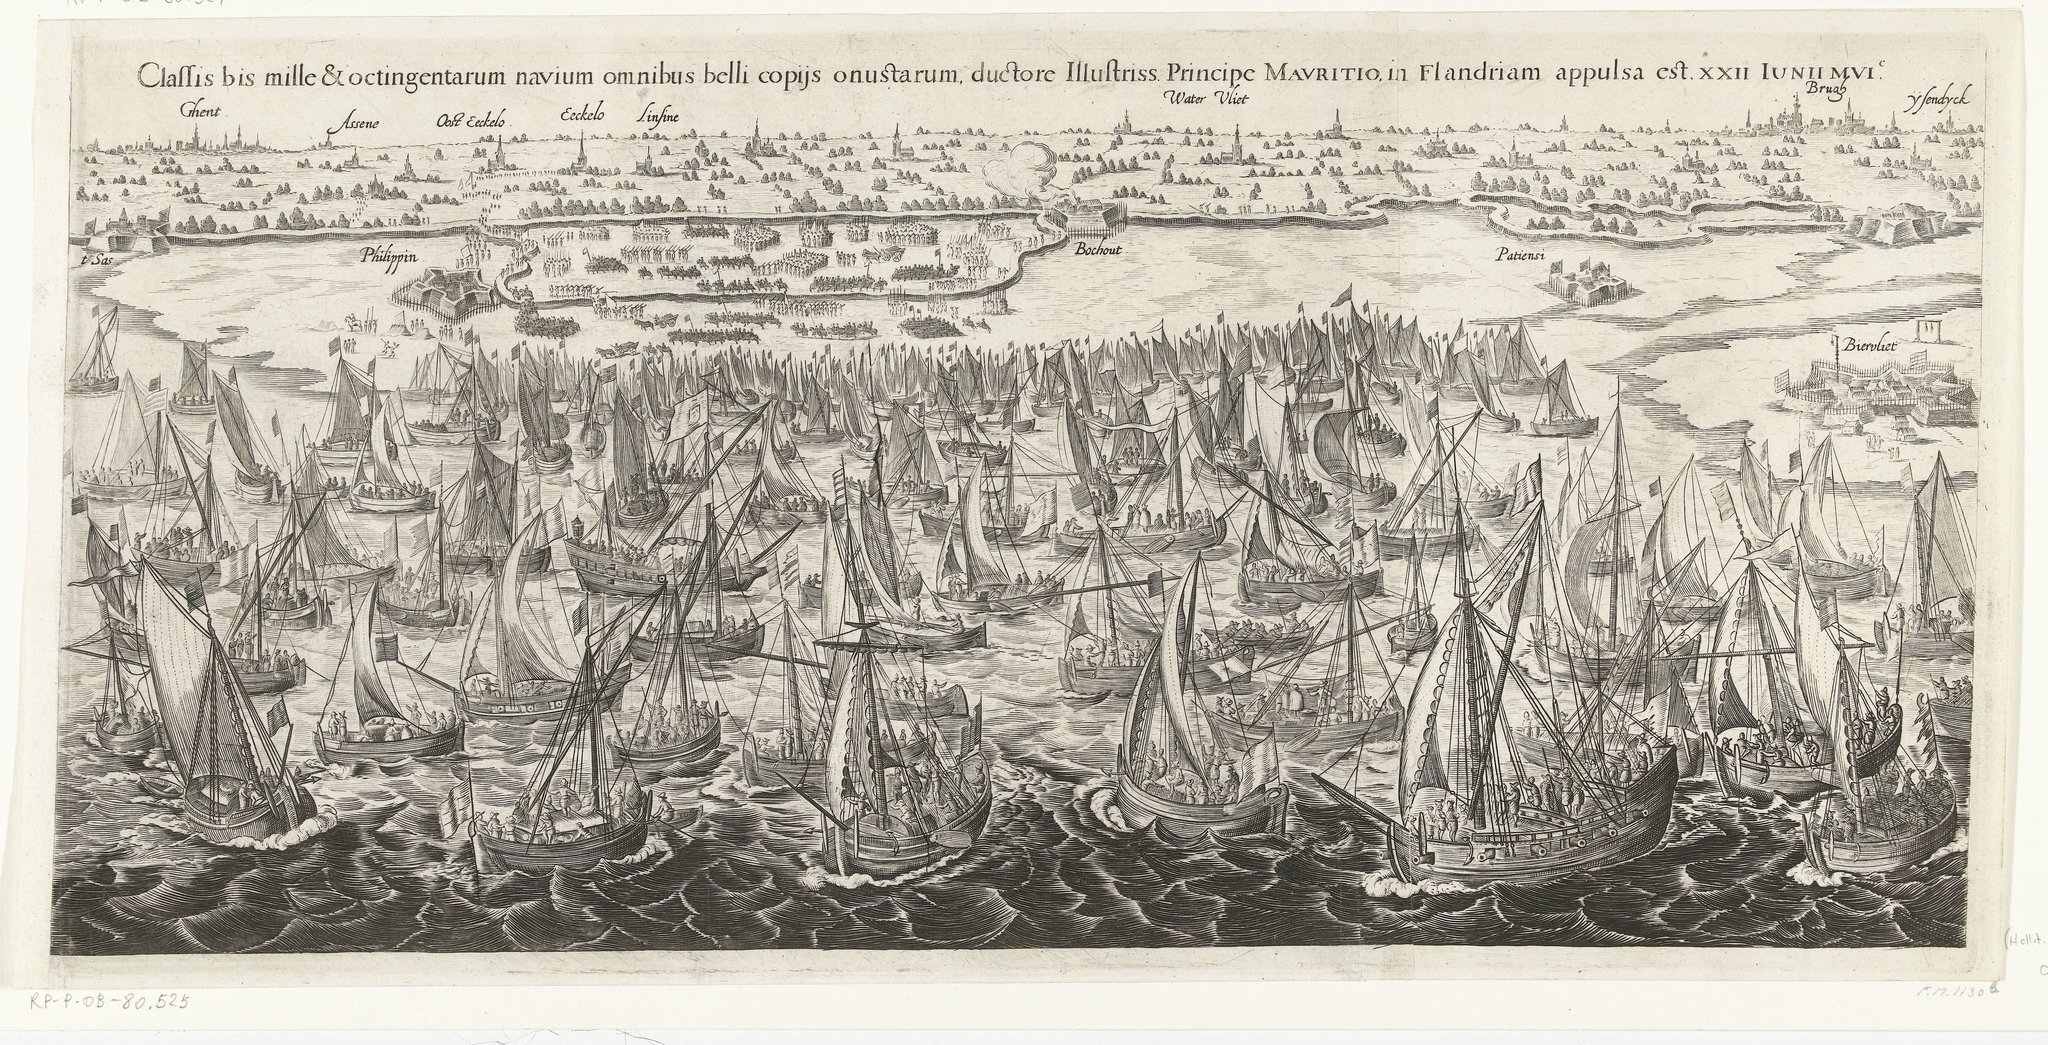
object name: print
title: De vlootlanding bij Philippine, 1600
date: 1610-1624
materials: paper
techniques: engraving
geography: northern netherlands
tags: maurice (prince of orange), troop movements, transportation (+ sailing-ships)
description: De vlootlanding bij Philippine. De Staatse vloot van Maurits voor Philippine waar manschappen aan boord worden genomen, 22 juni 1600. Tocht naar Oostende van het Staatse leger, 19-27 juni, 1600.